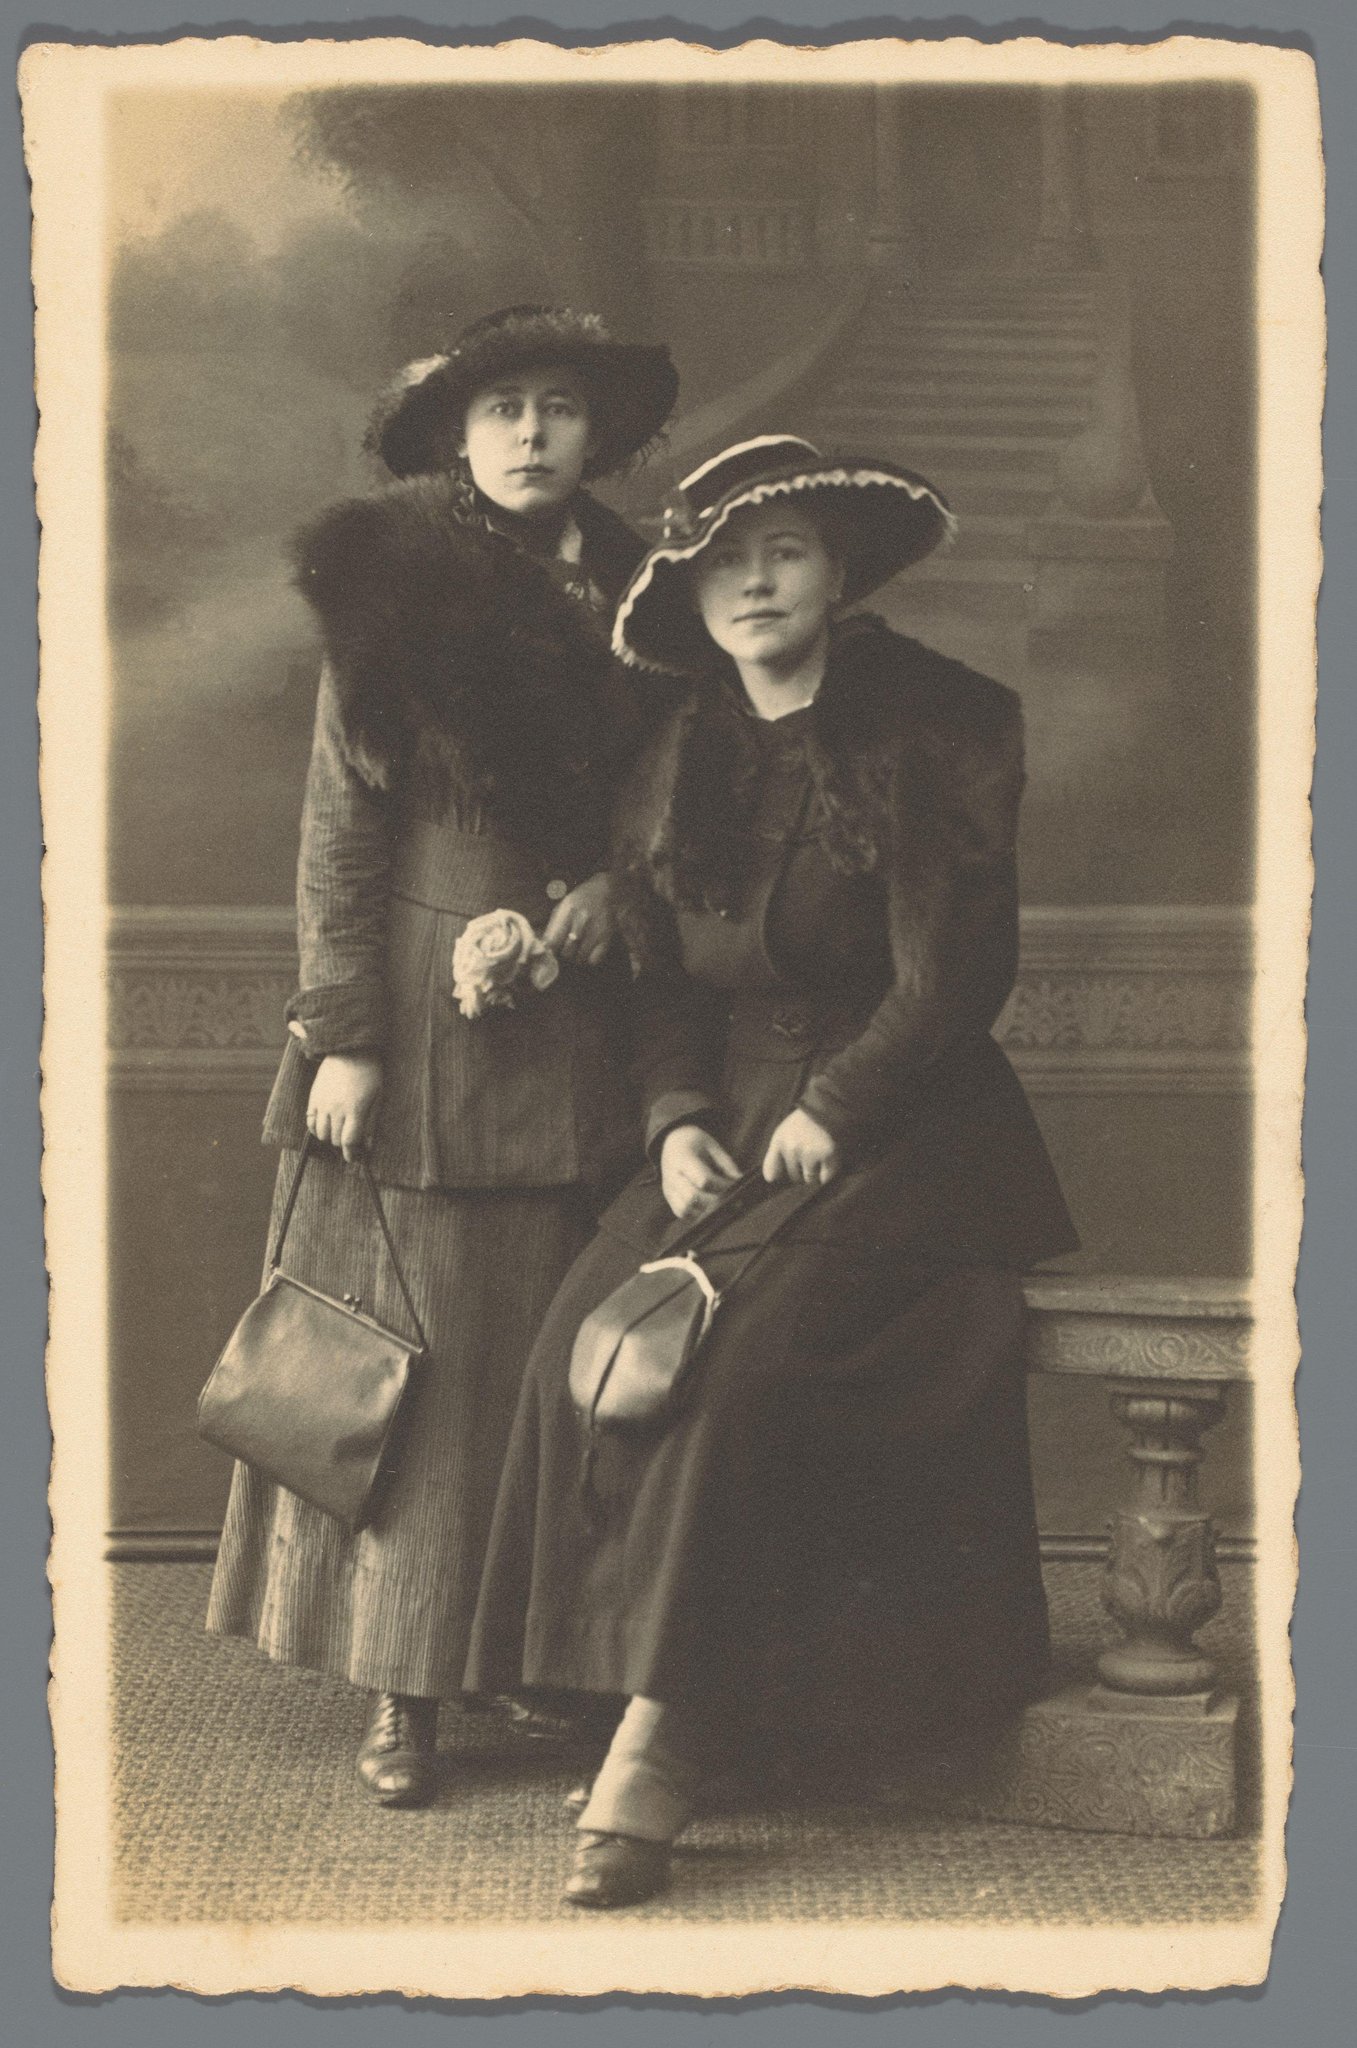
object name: ansichtkaart, prentbriefkaart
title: Portret van twee vrouwen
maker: Anonymous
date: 1920-1930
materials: photographic support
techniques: gelatin silver print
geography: germany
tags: anonymous historical person portrayed - bb - woman